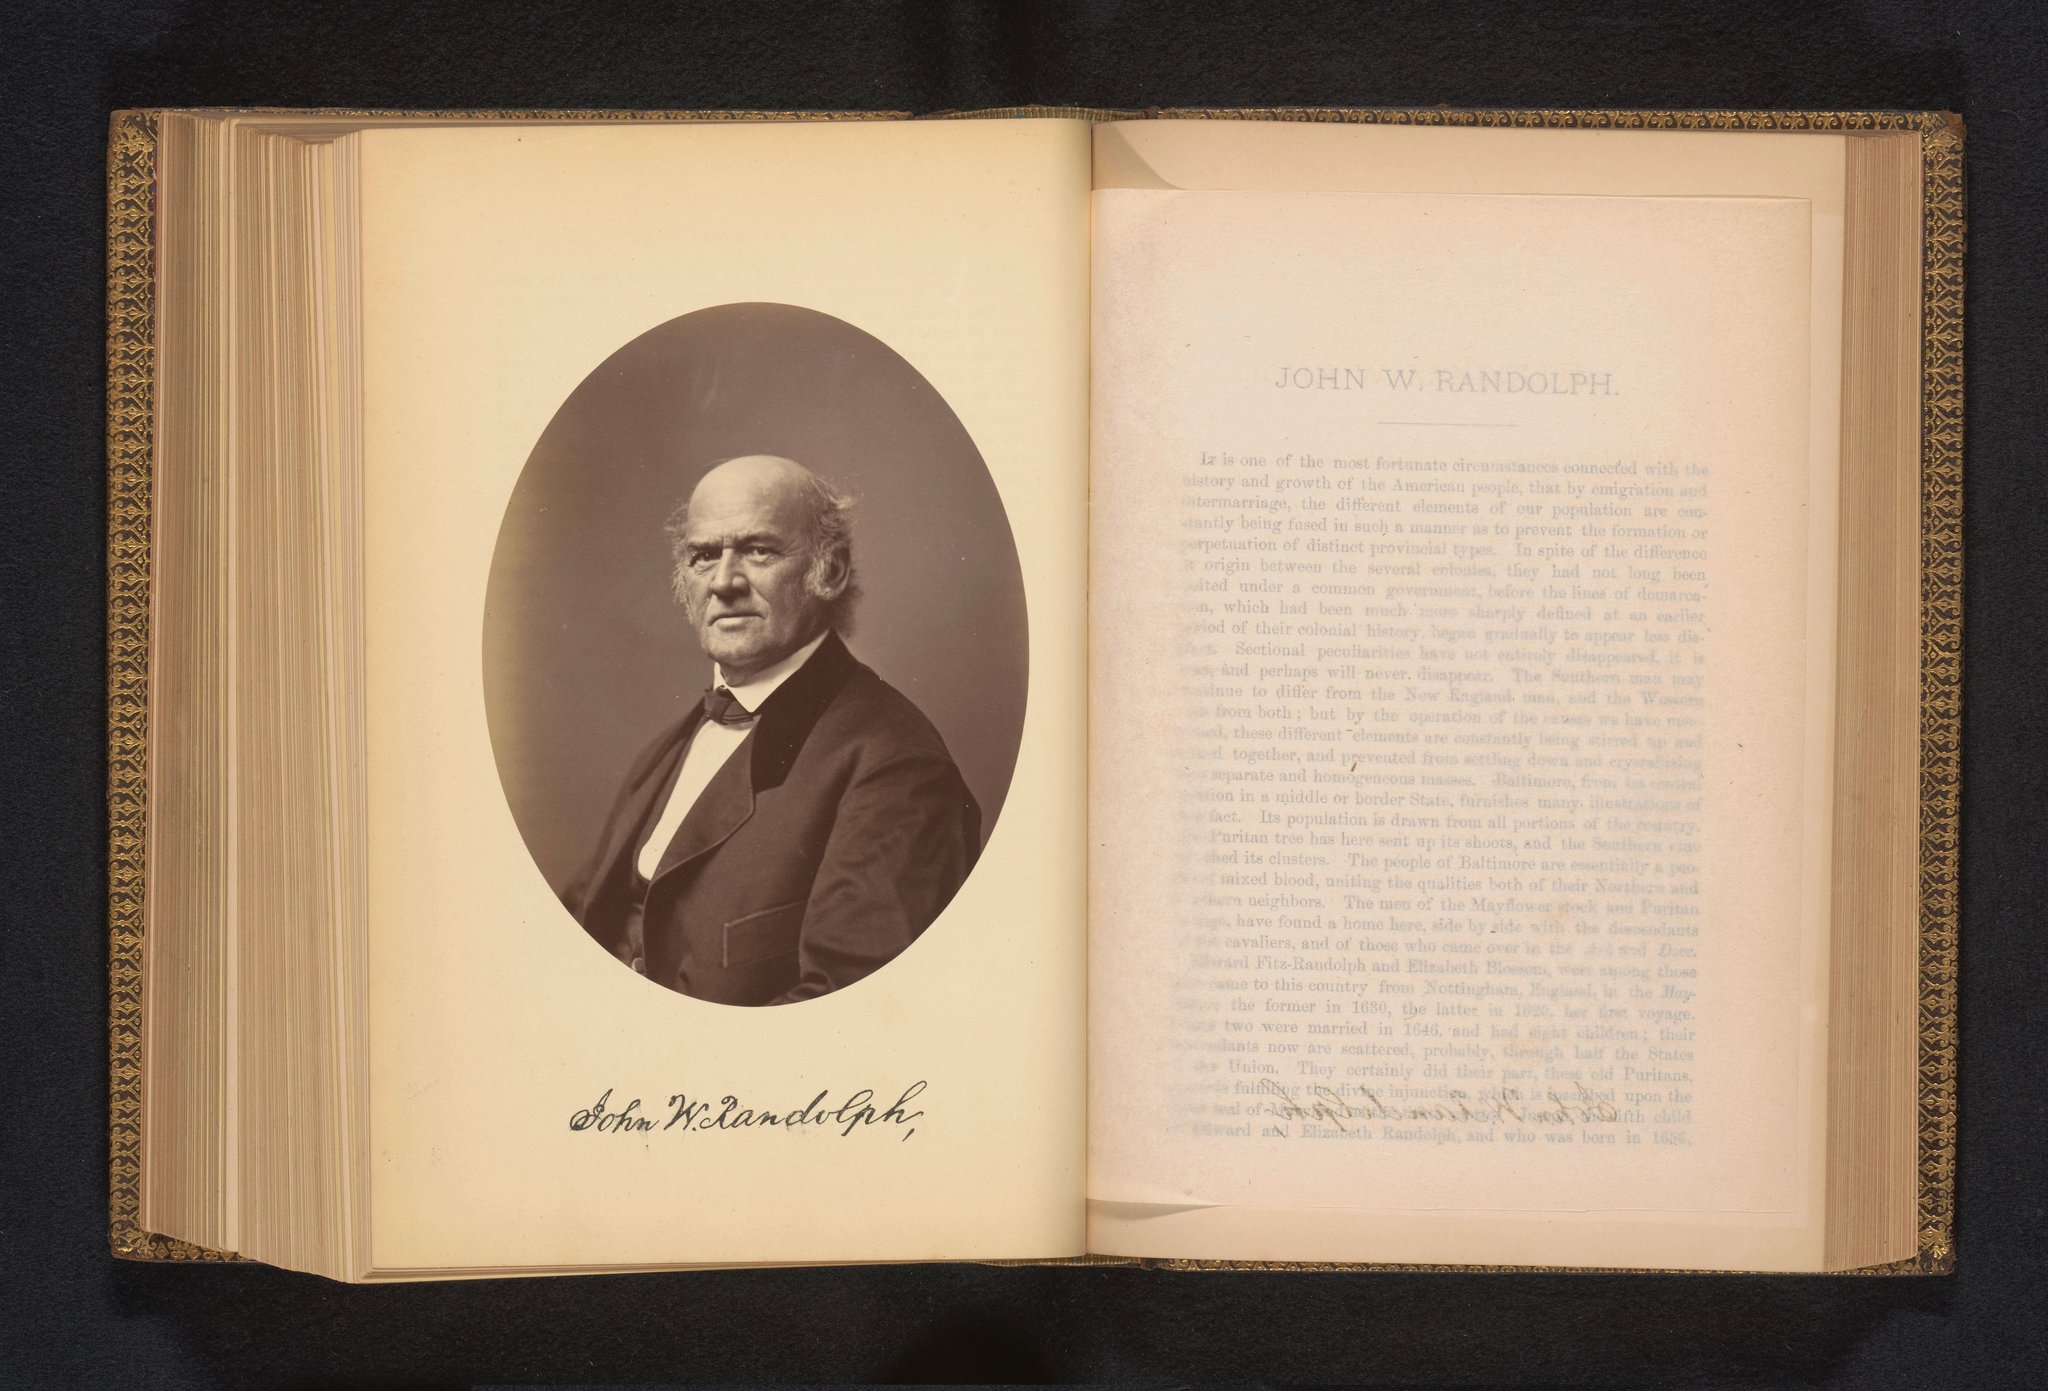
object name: page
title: John W. Randolph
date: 1866-1871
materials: photographic support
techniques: albumen print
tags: historical persons